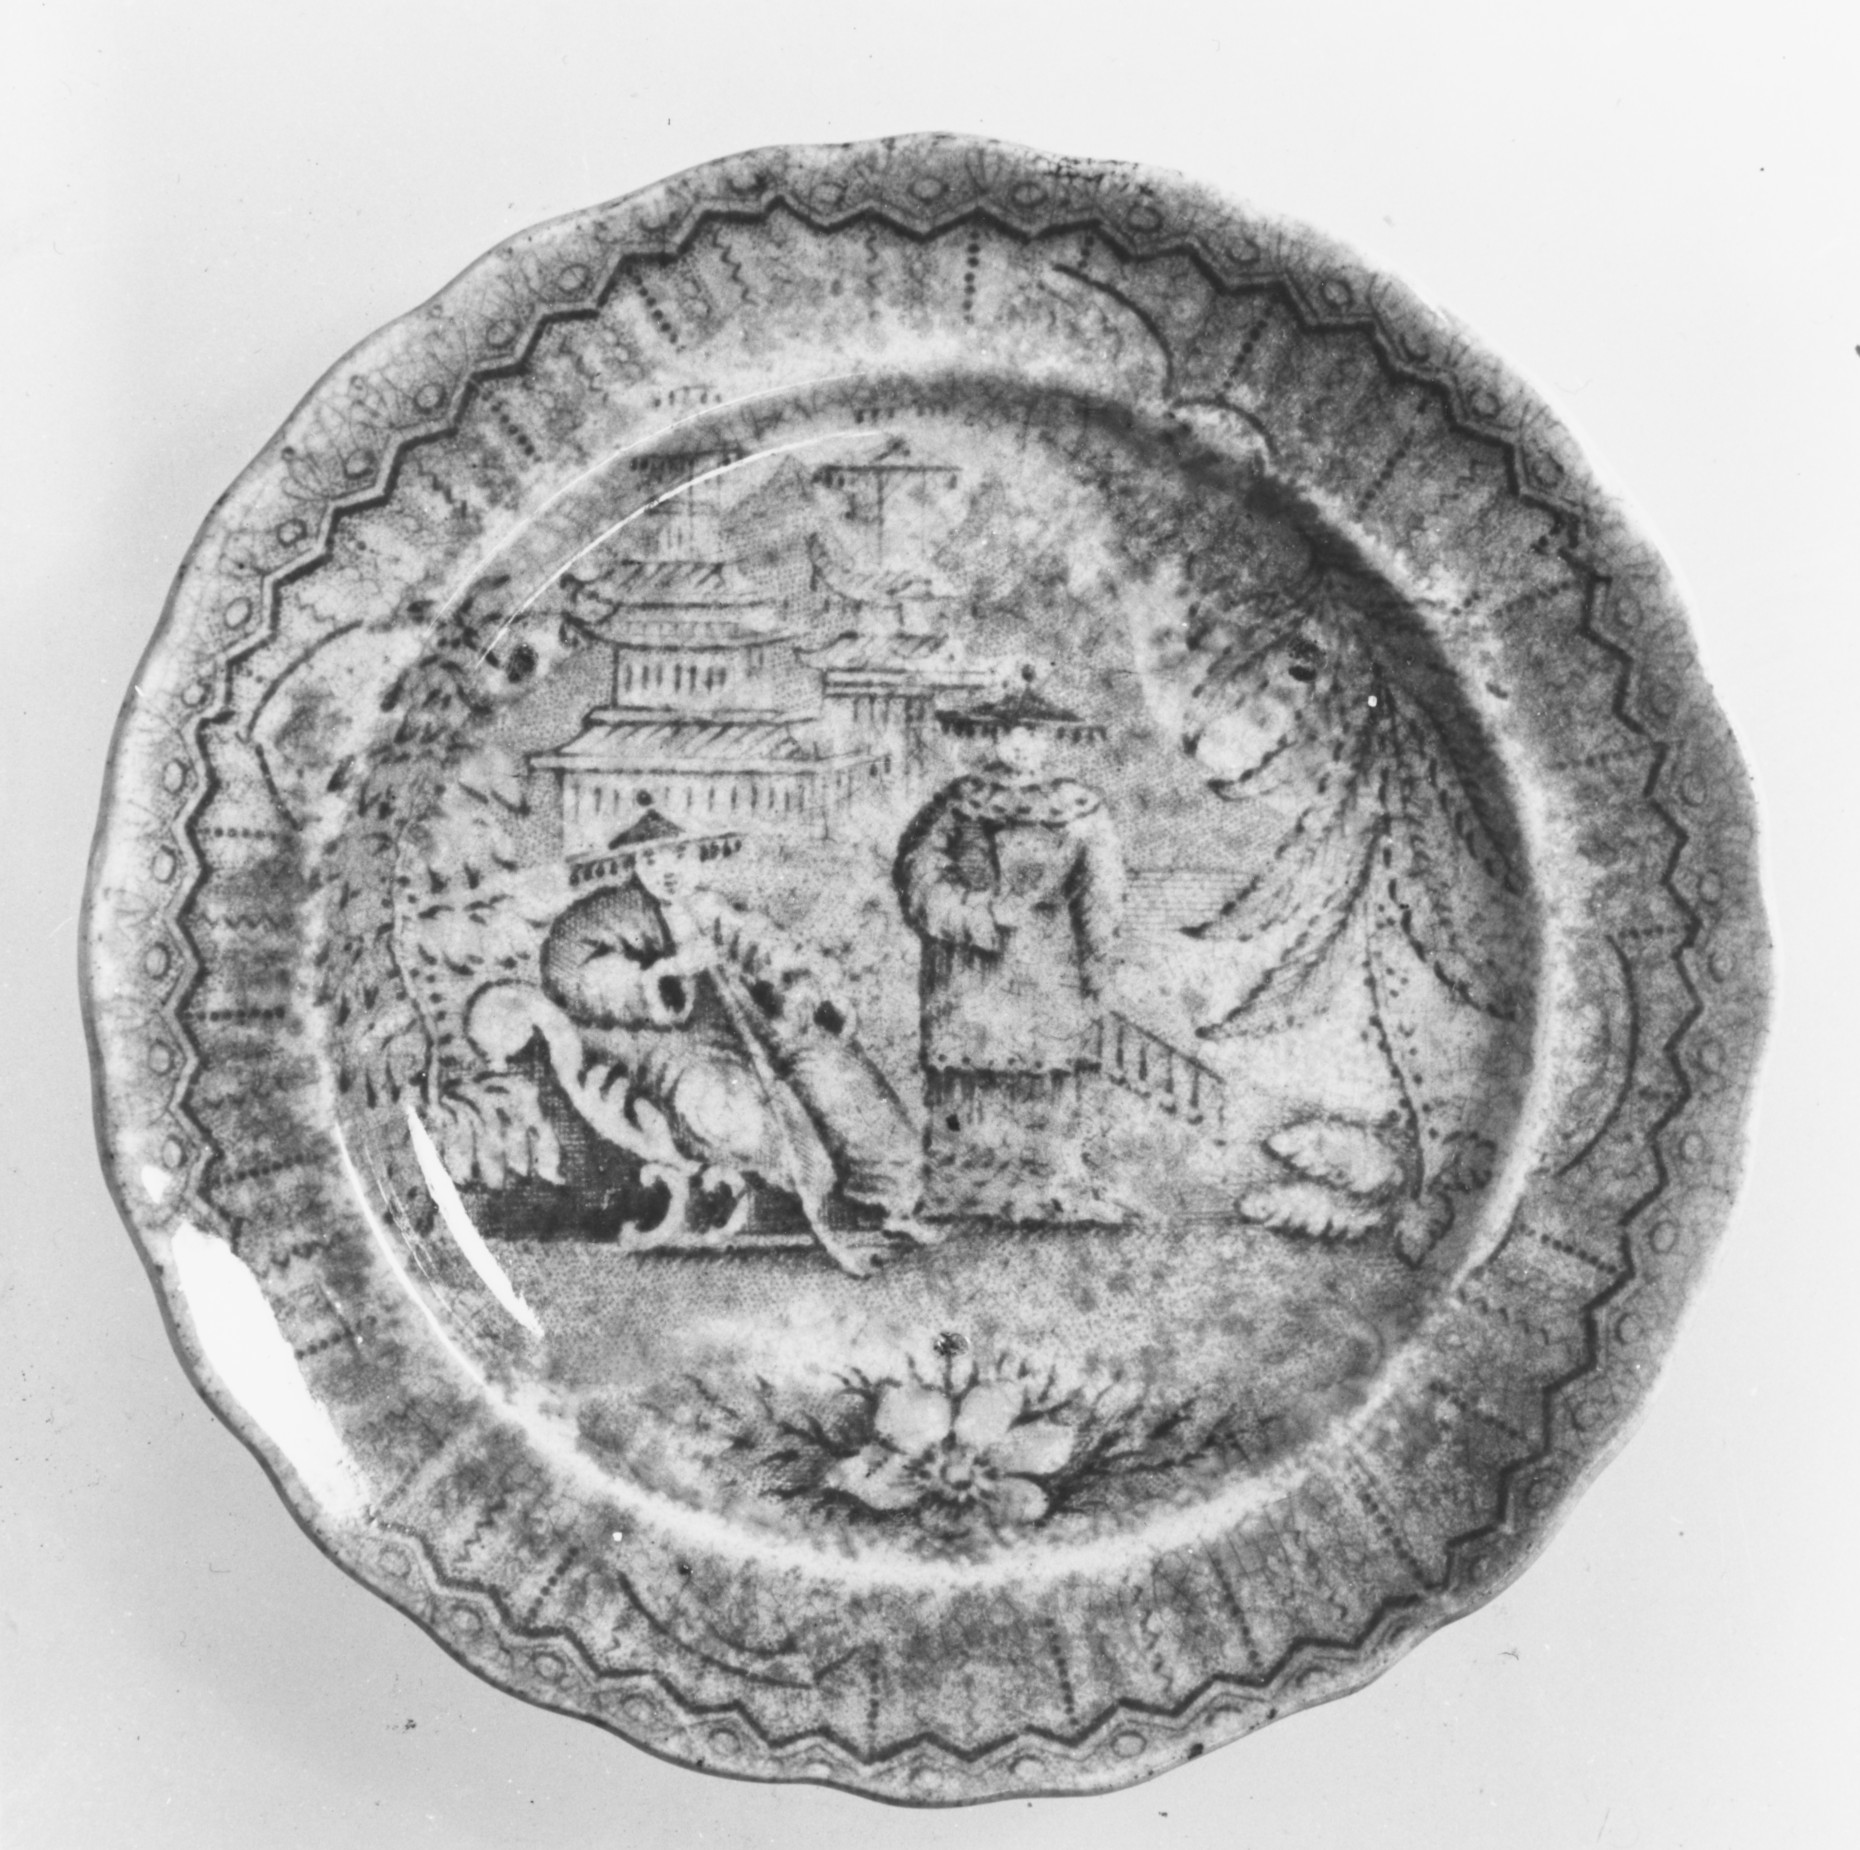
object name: cup plate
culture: british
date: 1830-1870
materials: earthenware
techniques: transfer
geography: england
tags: men